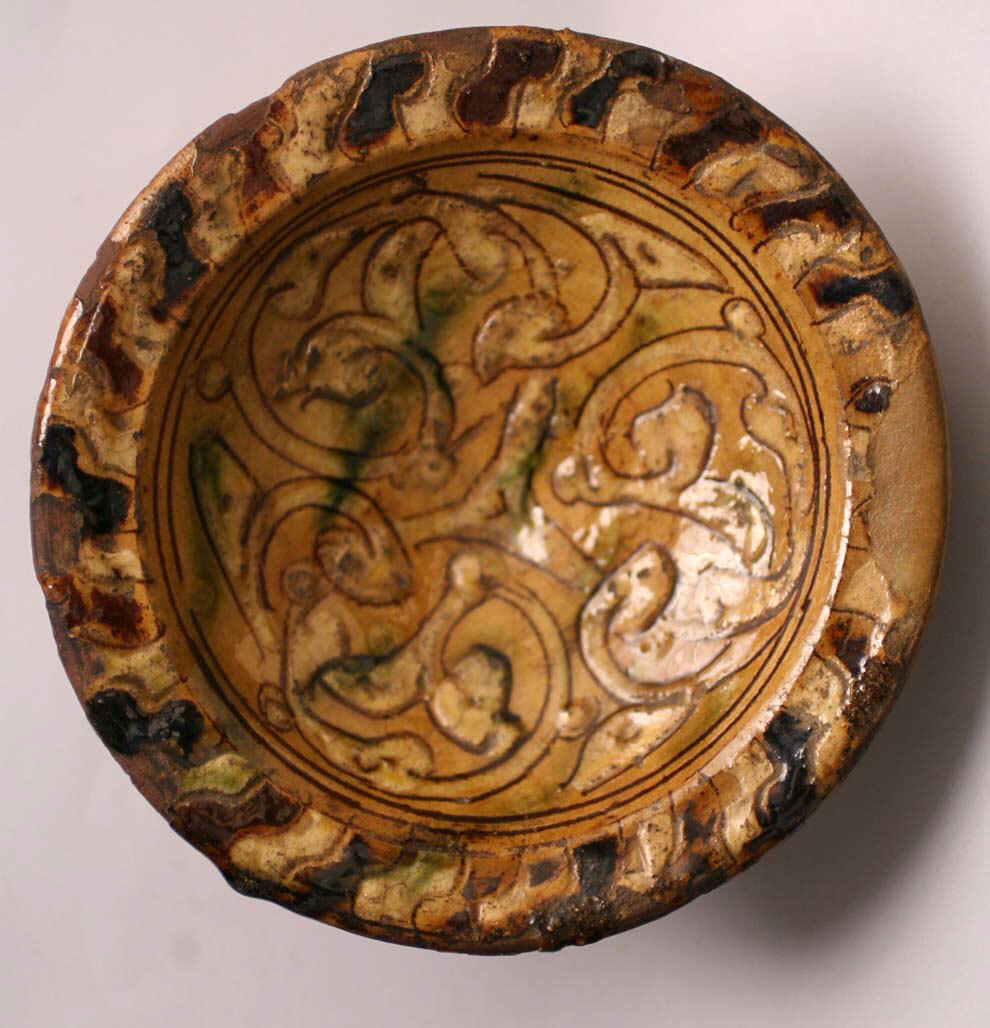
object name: bowl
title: "Sgraffito-ware" Bowl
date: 1301-1400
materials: earthenware, glaze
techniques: incising, polychrome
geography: egypt